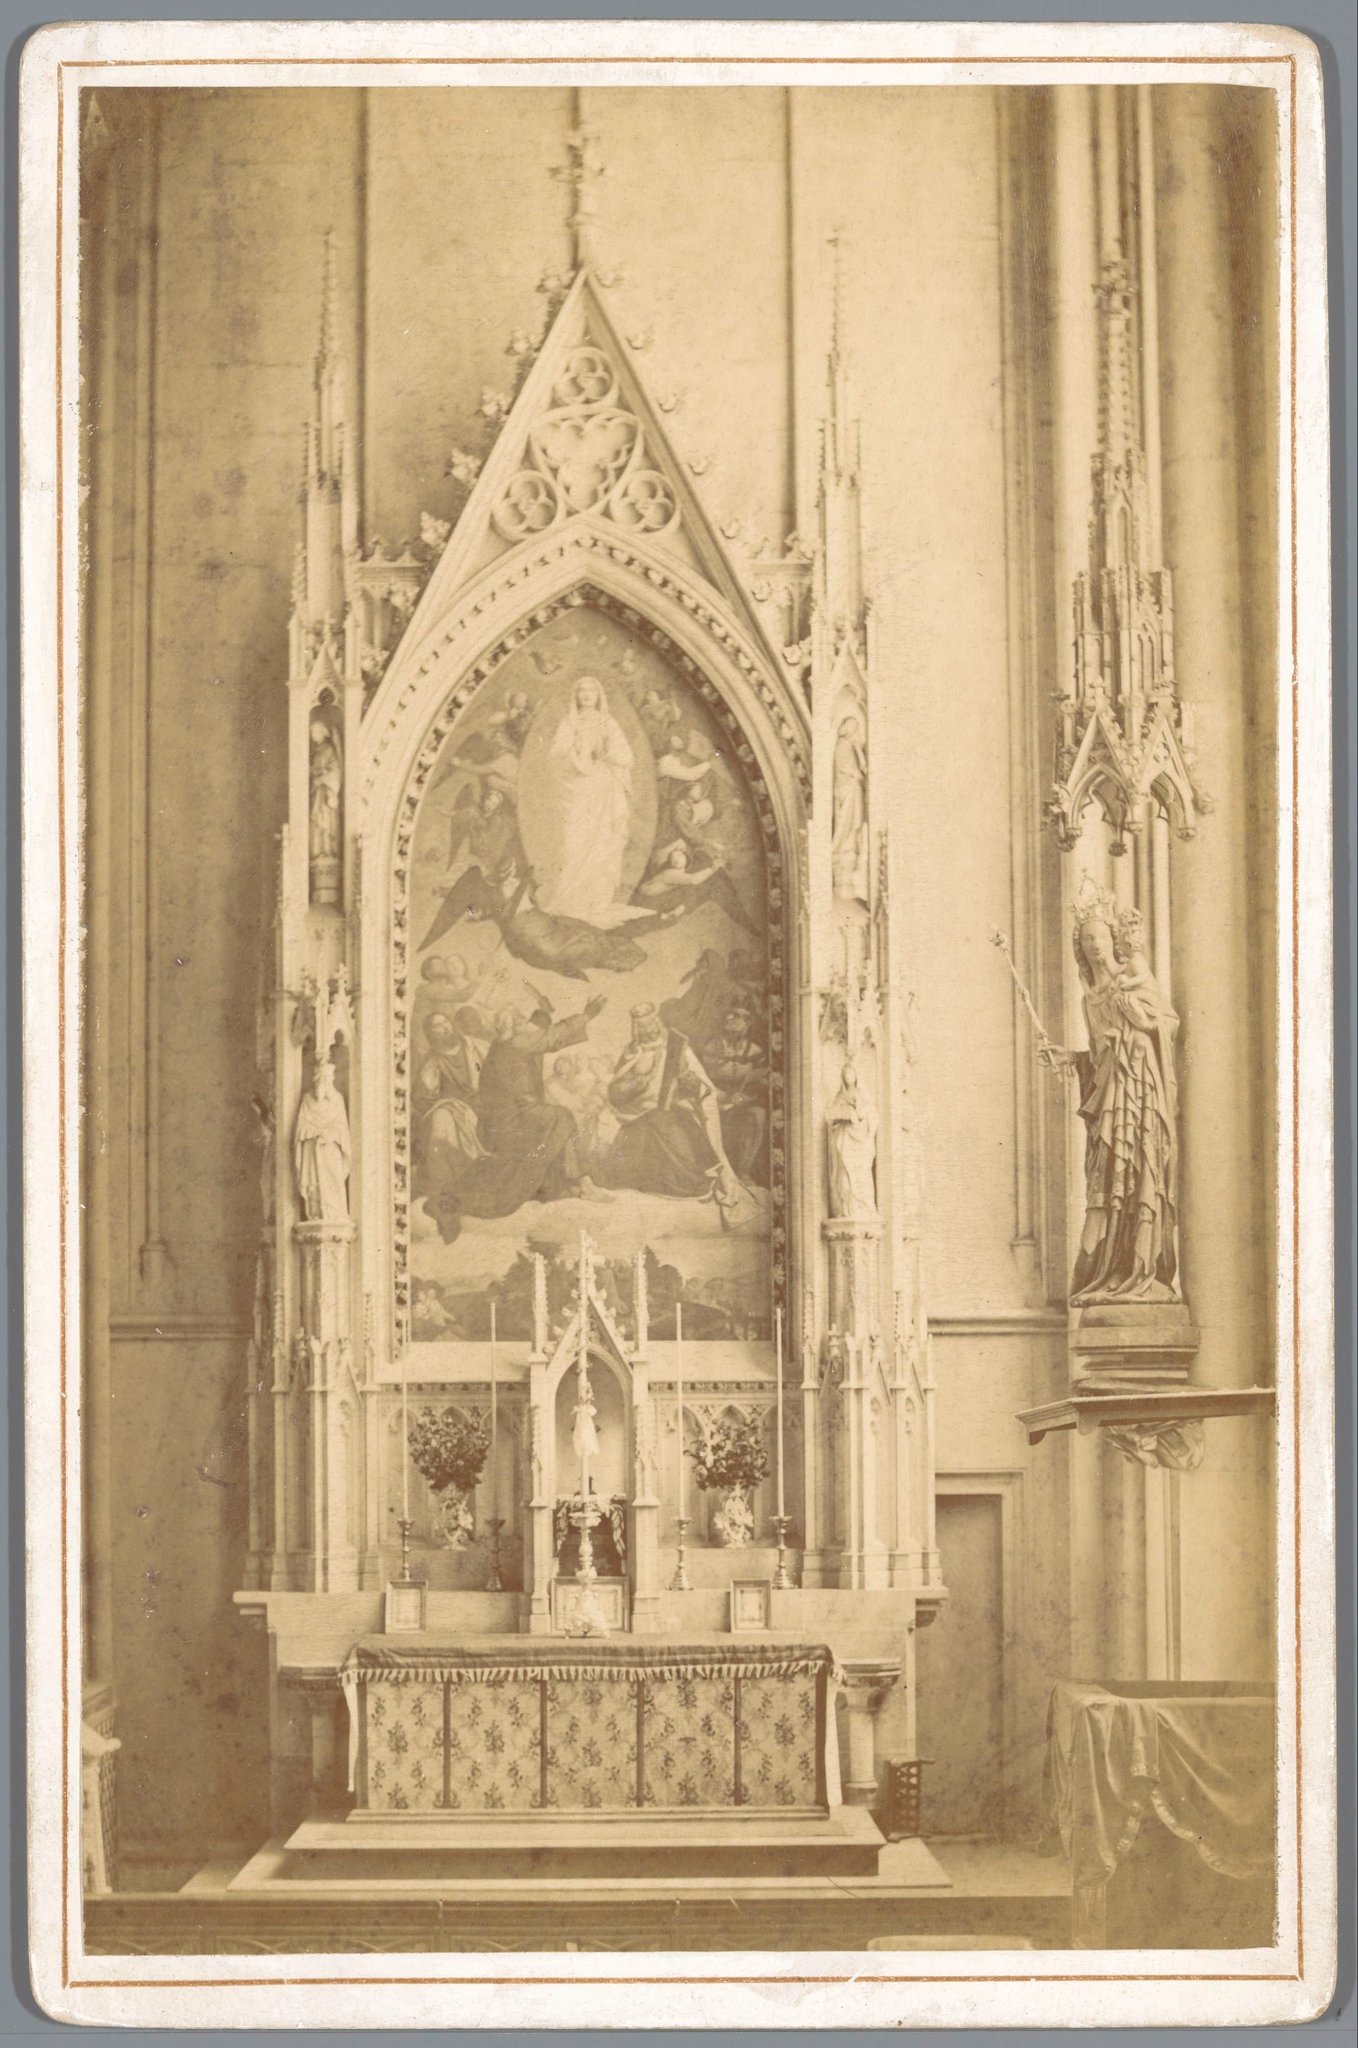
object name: cabinet photograph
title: Kapel in de Dom van Keulen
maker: Anonymous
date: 1870-1890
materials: cardboard, paper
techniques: albumen print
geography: cologne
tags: parts of church interior: chapel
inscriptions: label: ‘Kunsthandlung/ von/ Geschw. Michiels/ 31 Passage/ Cöln.’